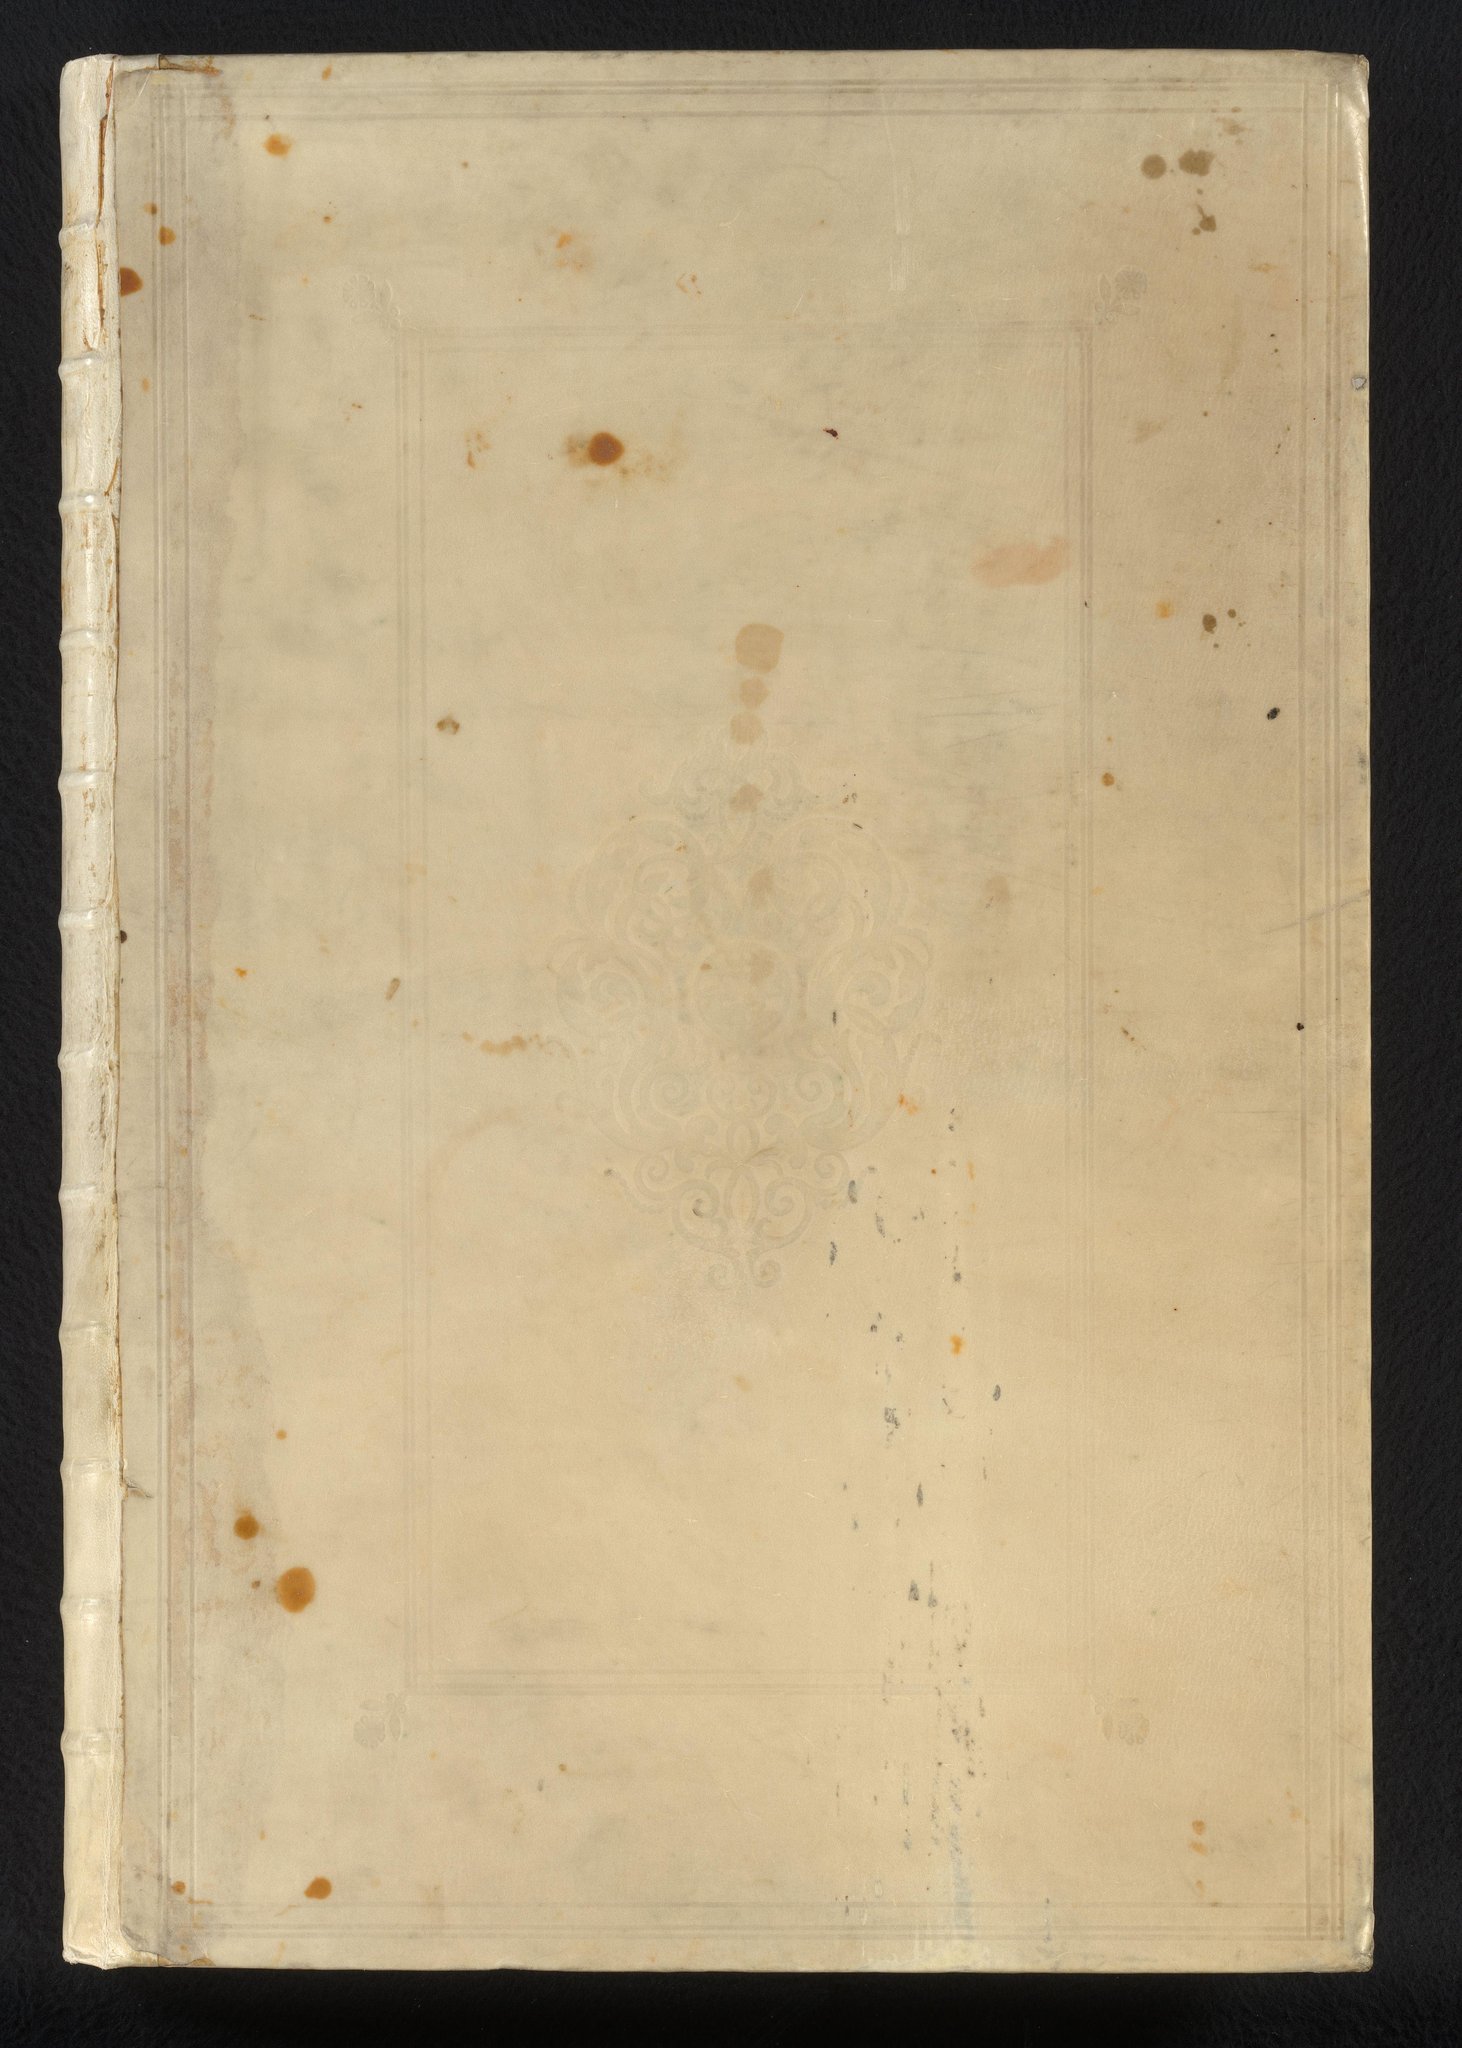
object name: book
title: Metamorphosis insectorum Surinamensium. : In qua erucæ ac vermes Surinamenses ... in quibus reperta sunt ... / omnia in America ad vivùm naturali magnitudine picta atque descripta per Mariam Sibyllam Merian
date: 1705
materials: parchment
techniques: blind stamped, etching, hand coloring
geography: amsterdam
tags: suriname